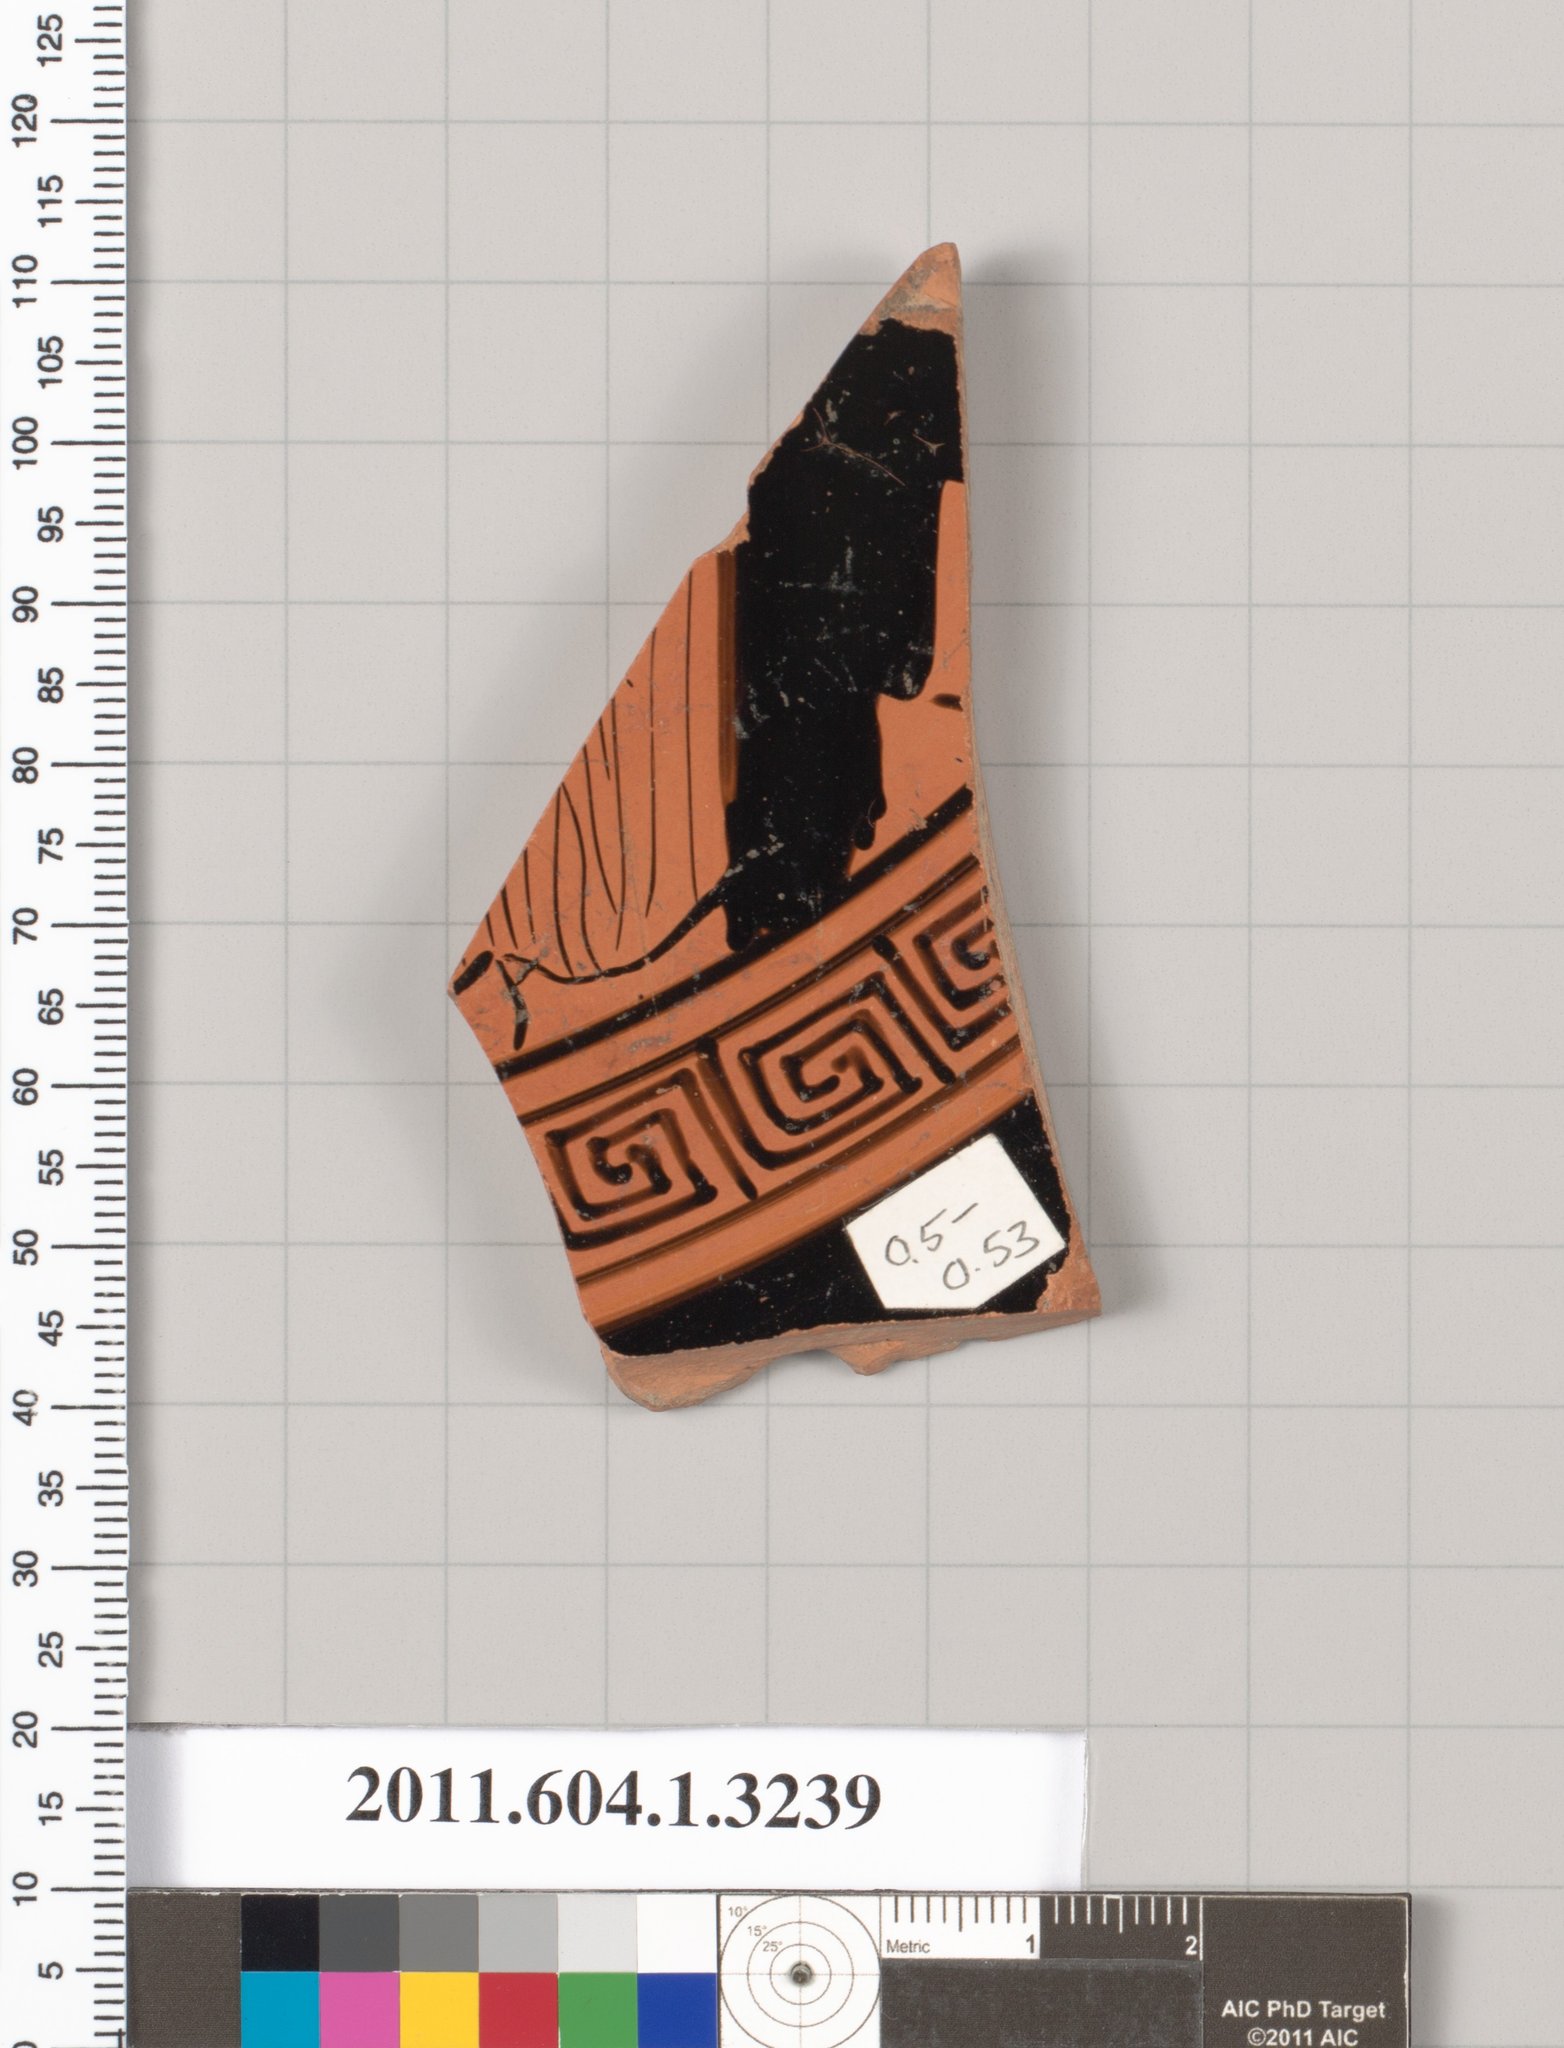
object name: kylix fragment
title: Terracotta fragment of a kylix (drinking cup)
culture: greek, attic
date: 467-435 BCE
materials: terracotta